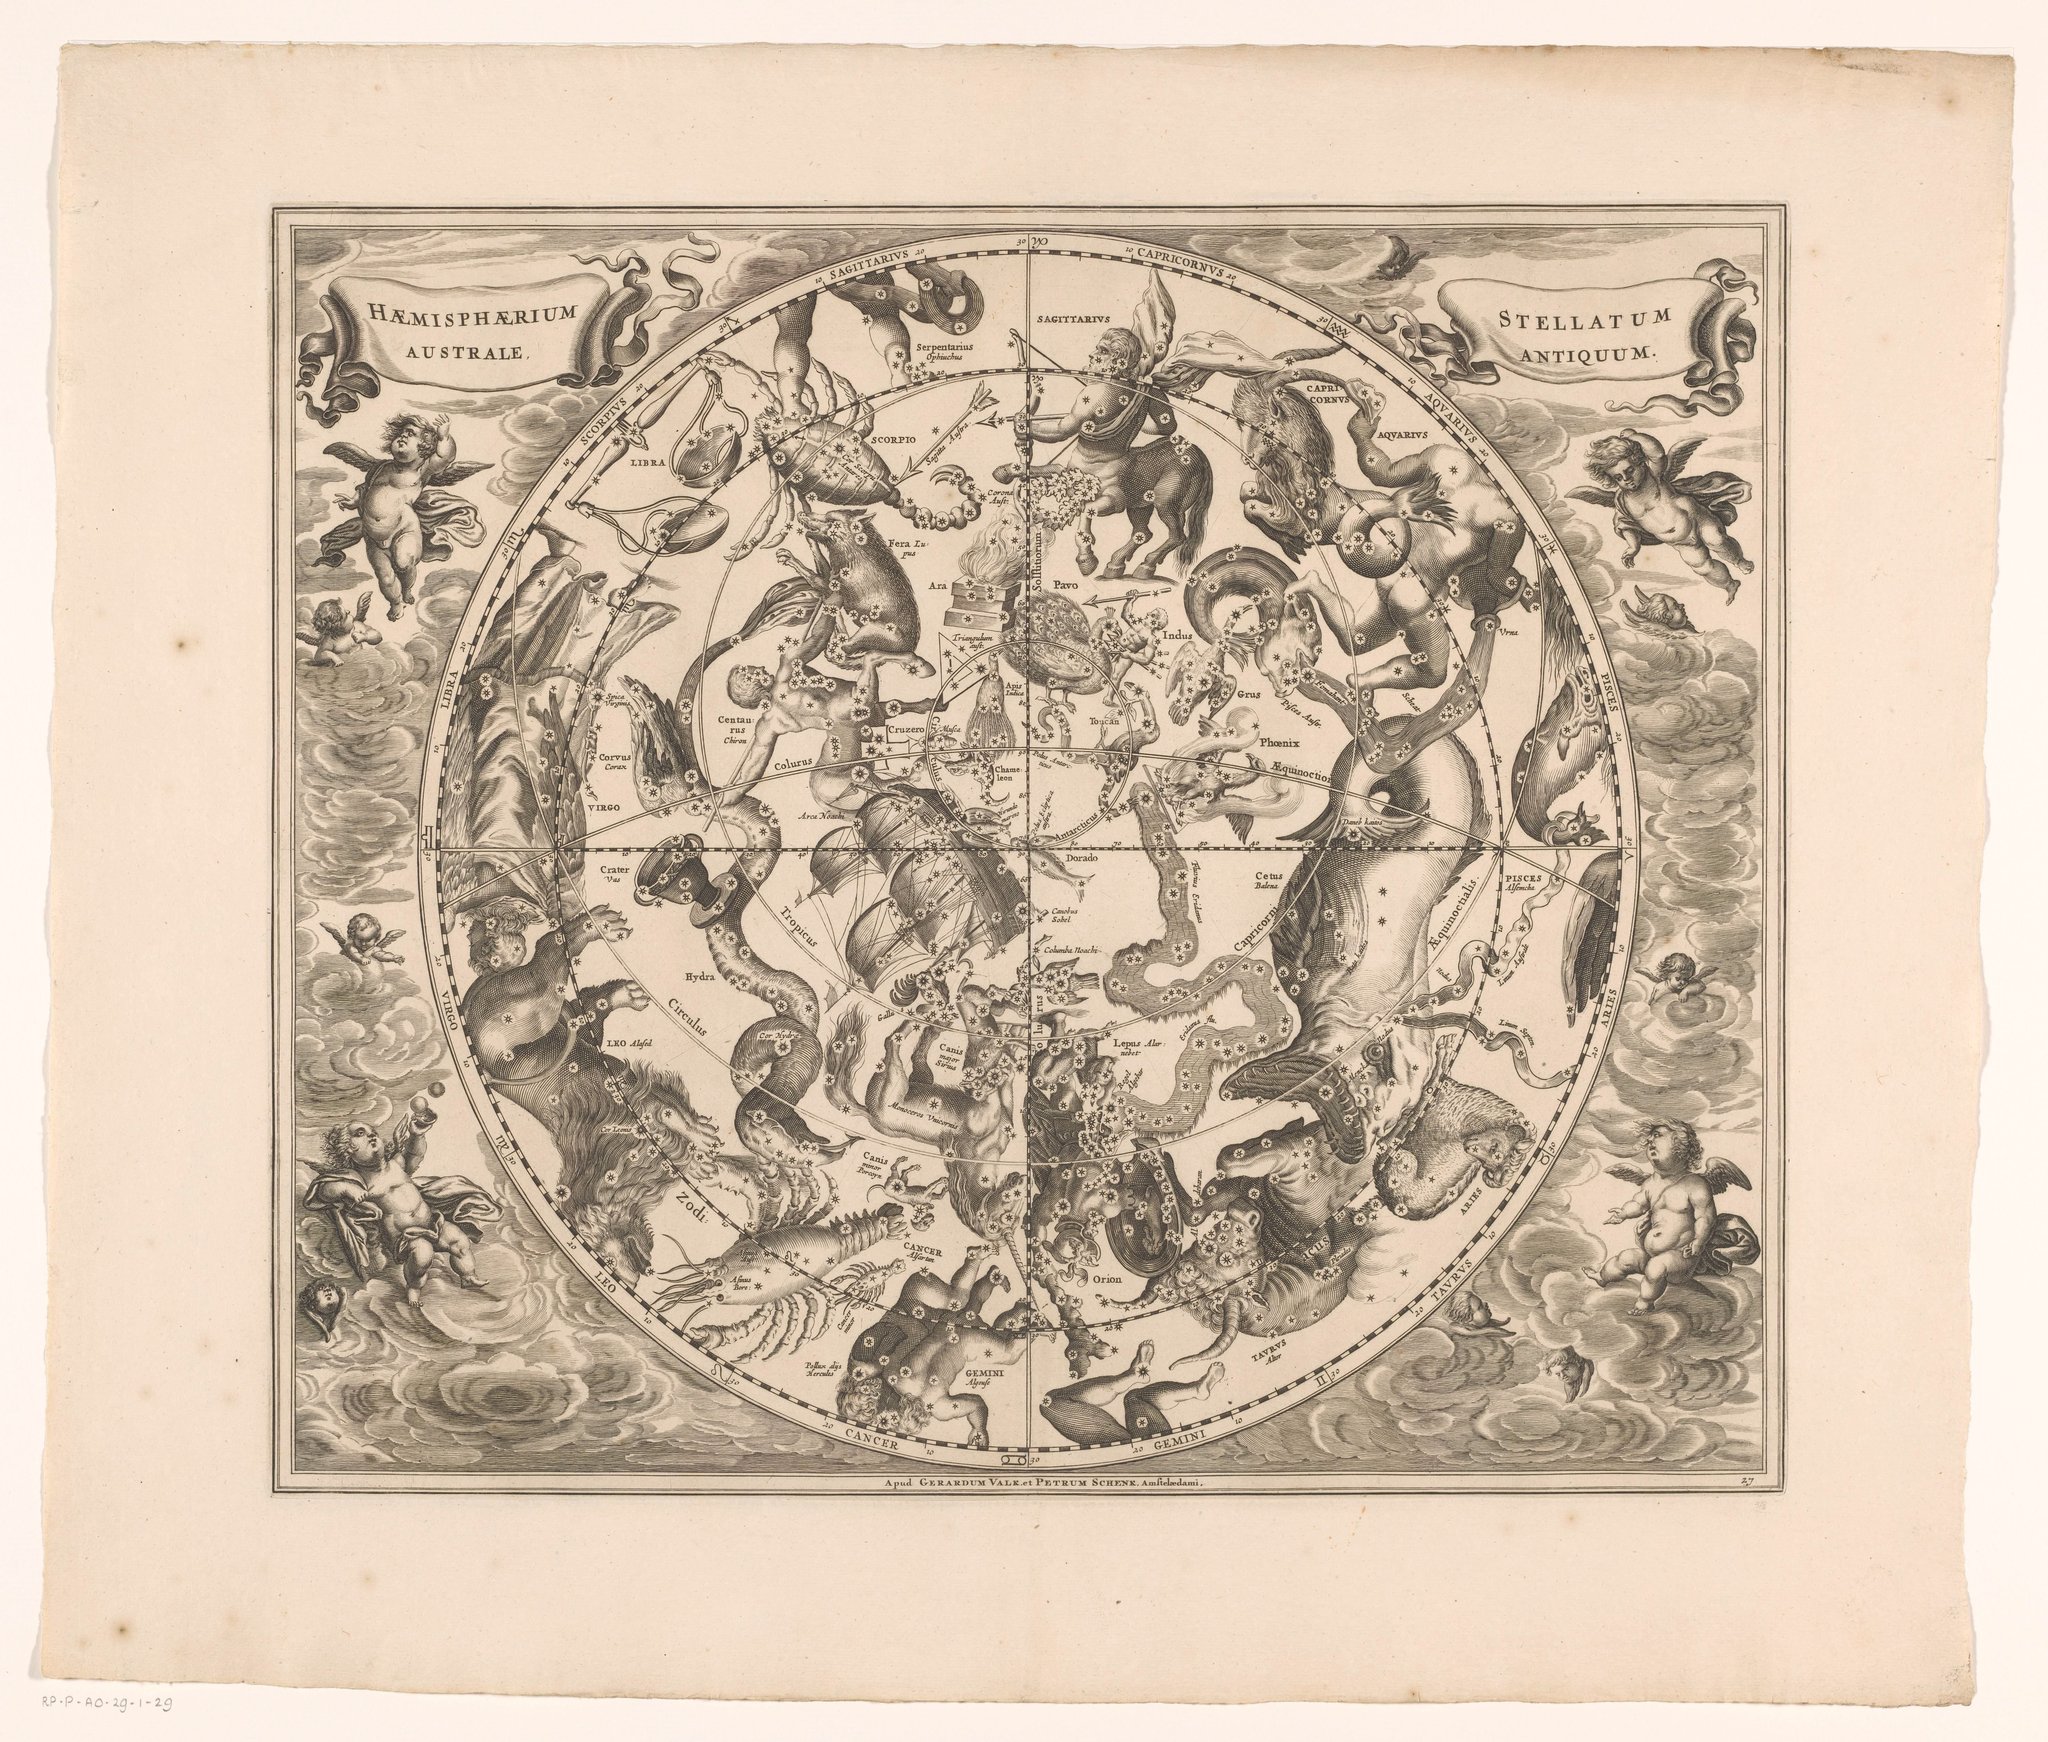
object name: print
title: Haemisphaerium stellatum australe antiquum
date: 1660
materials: paper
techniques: engraving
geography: amsterdam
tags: zodiac; the twelve zodiacal signs together, star-chart, star map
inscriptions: collector's mark: Lugt 2228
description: Prent ook gebruikt in: Cellarius, Andreas. Harmonia Macrocosmica seu Atlas Universalis et Novus. Amsterdam: Pieter Schenk (I) en Gerard Valck, 1708. Zie ook: Gent, Rob van. De hemelatlas van Andreas Cellarius: het meesterwerk van een vergeten Hollandse kosmograaf. In: Caert-Thresoor, jaargang 19, nr. 1, 2000.